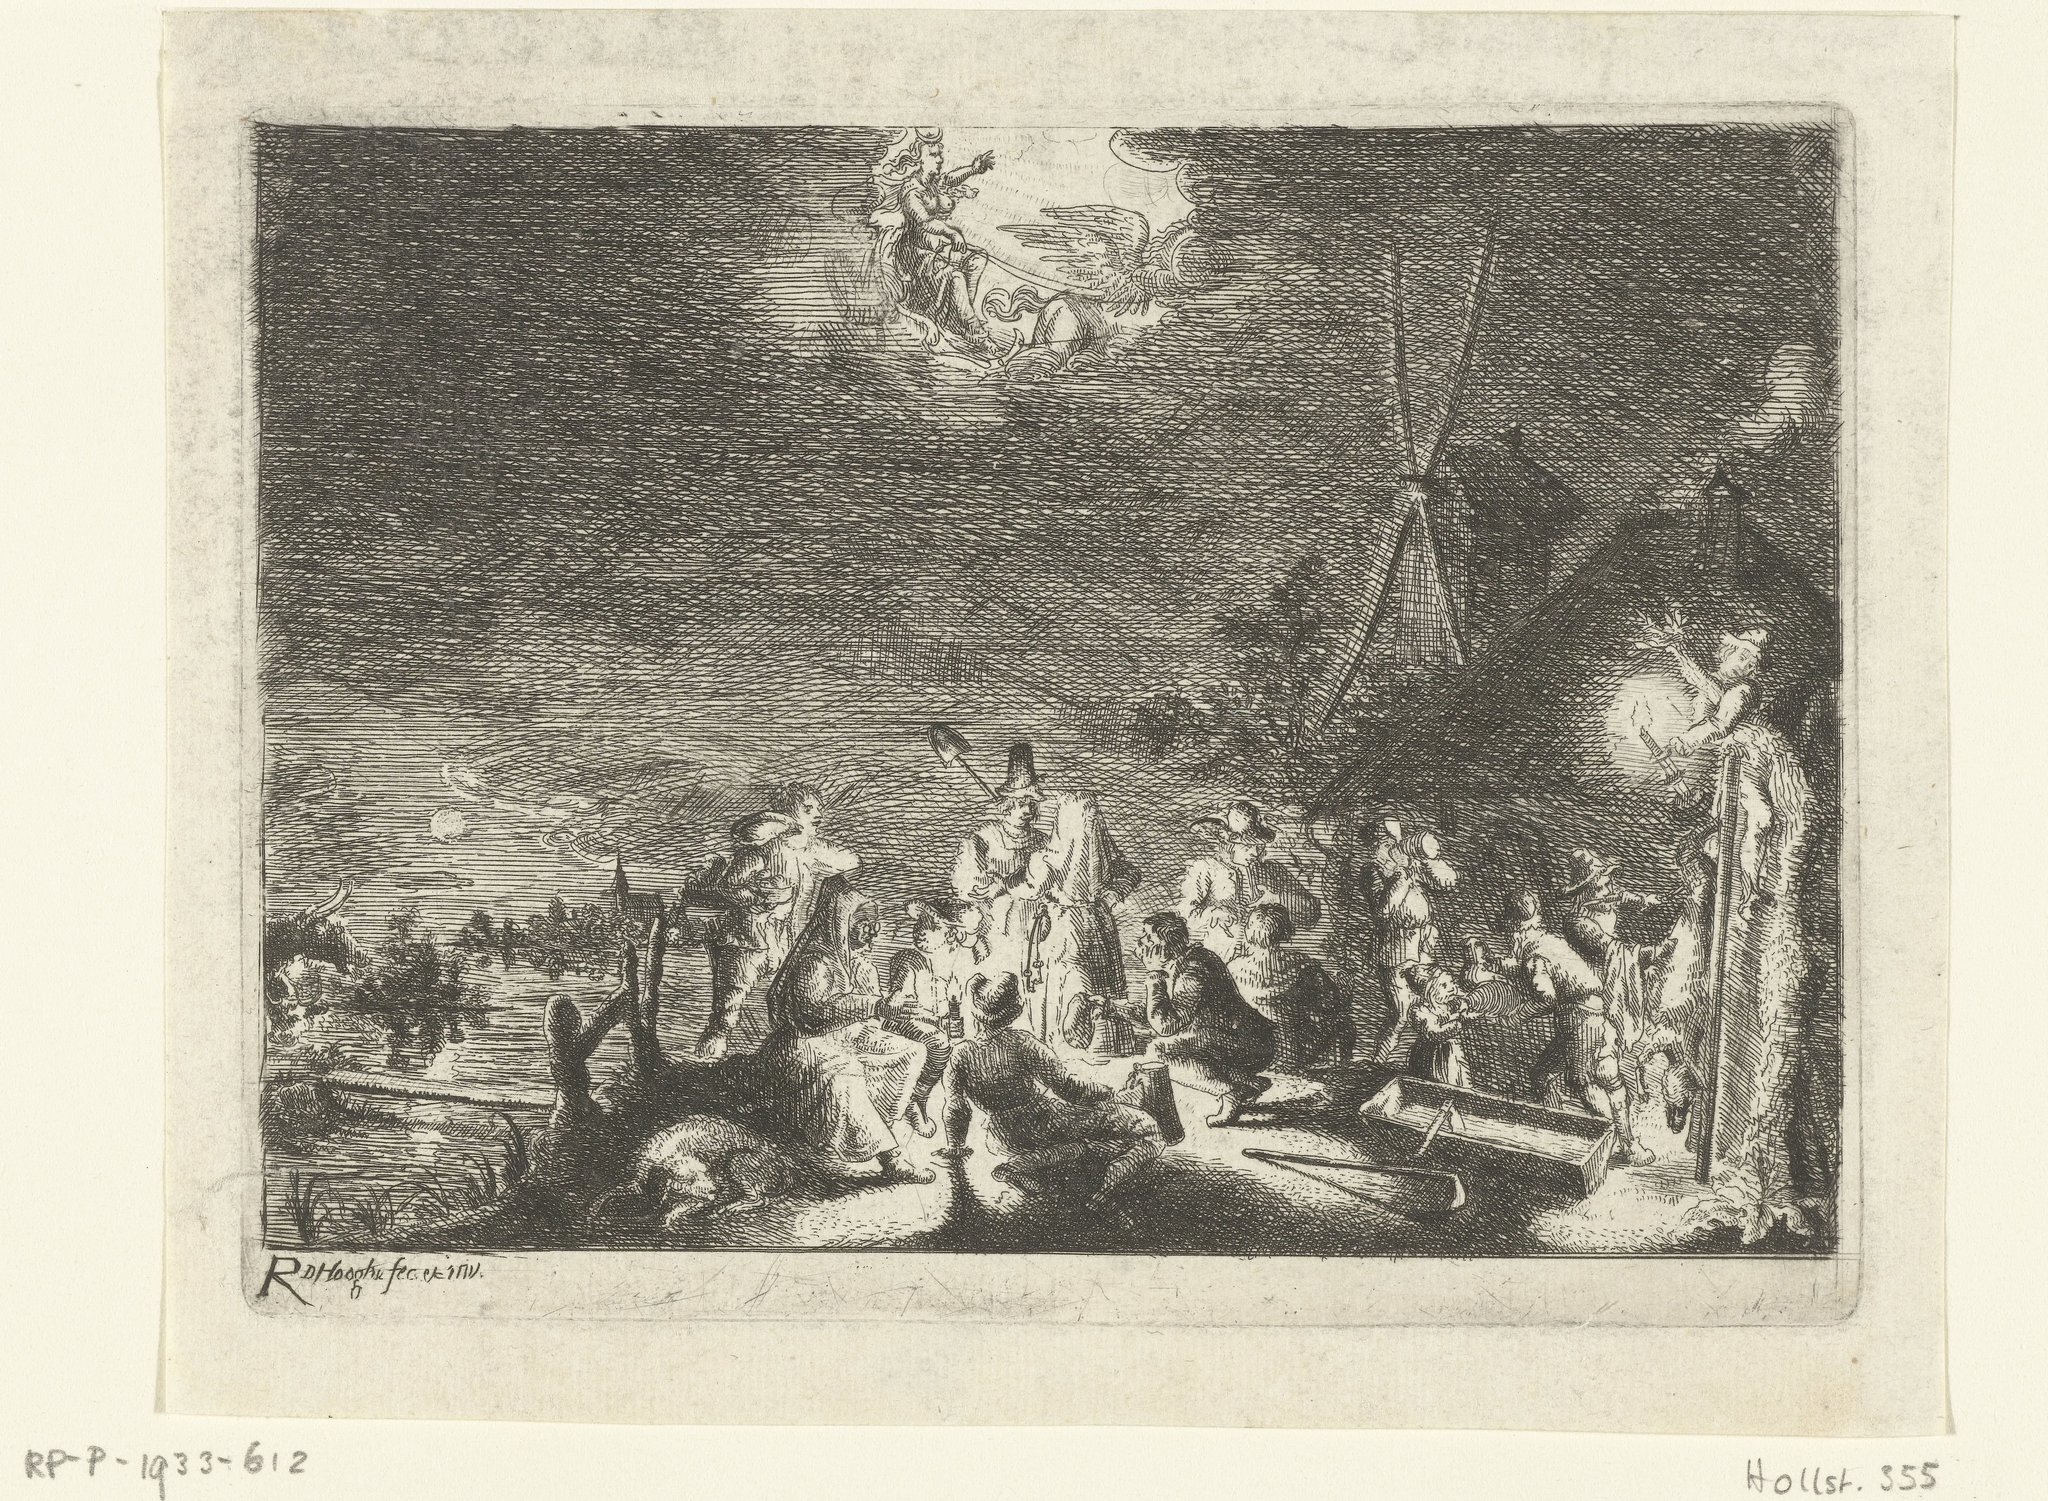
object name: print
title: Viering van het midwinter lichtfeest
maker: romeyn de hooghe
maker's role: draughtsman, goldsmith, painter, print maker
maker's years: 1645-1708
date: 1655-1667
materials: paper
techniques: etching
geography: netherlands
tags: diana as moon-goddess, i.e. luna (selene), winter solstice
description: Landschap met de nachtelijke viering van het midwinter lichtfeest met in de lucht de maangodin.